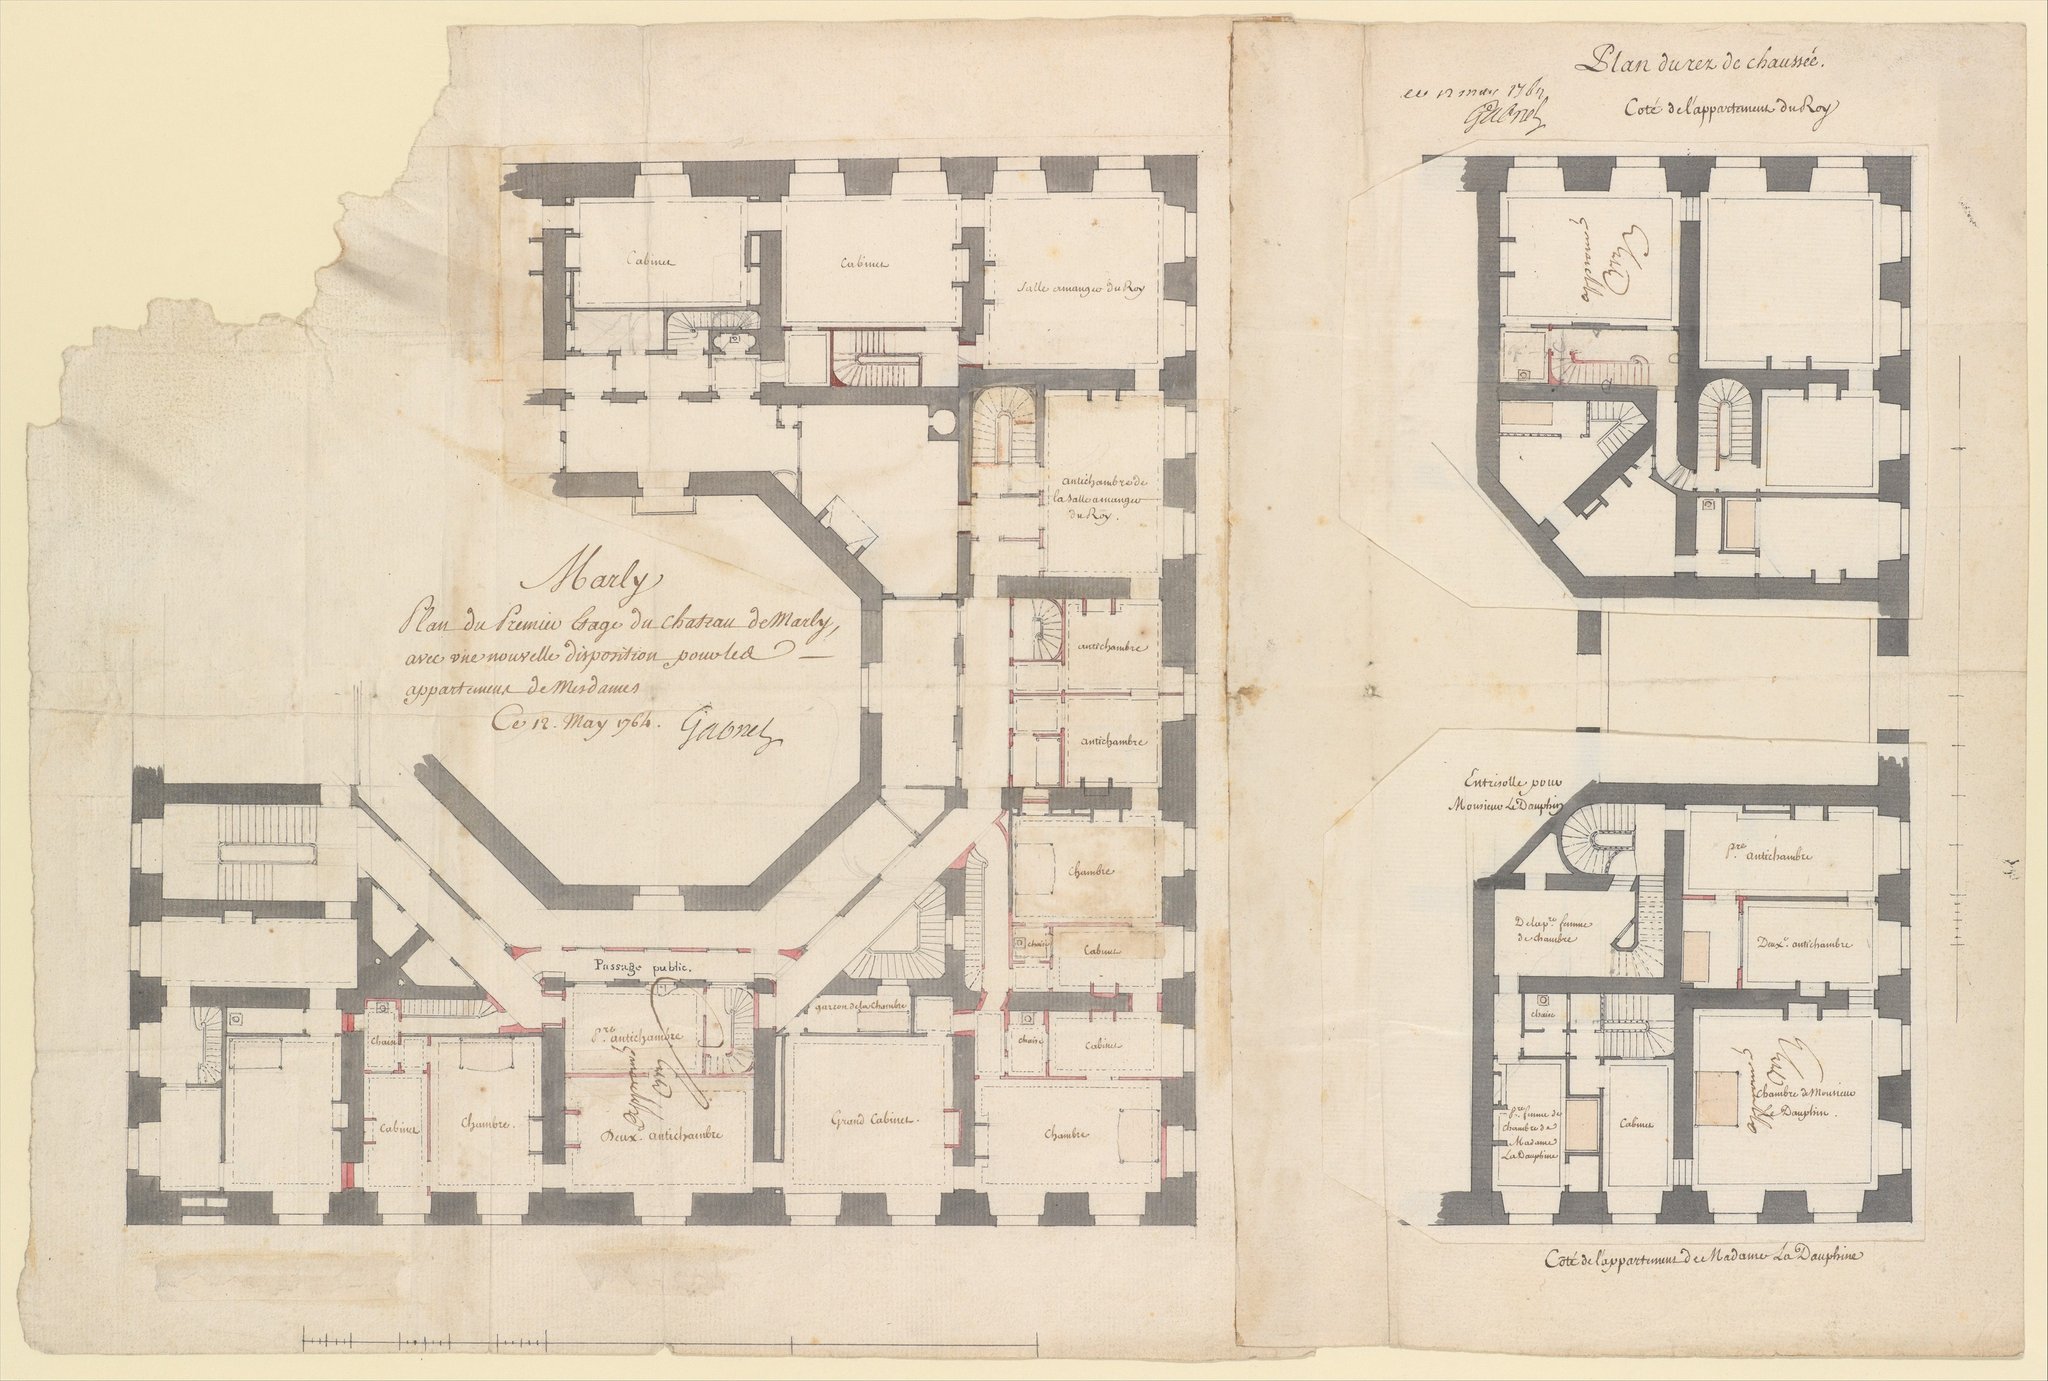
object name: drawing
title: Plans of the Ground and First Floors of the Chateau of Marly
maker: ange jacques gabriel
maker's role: artist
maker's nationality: french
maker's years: 1698-1782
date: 1764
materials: graphite, ink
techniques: brush, pen, wash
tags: architecture